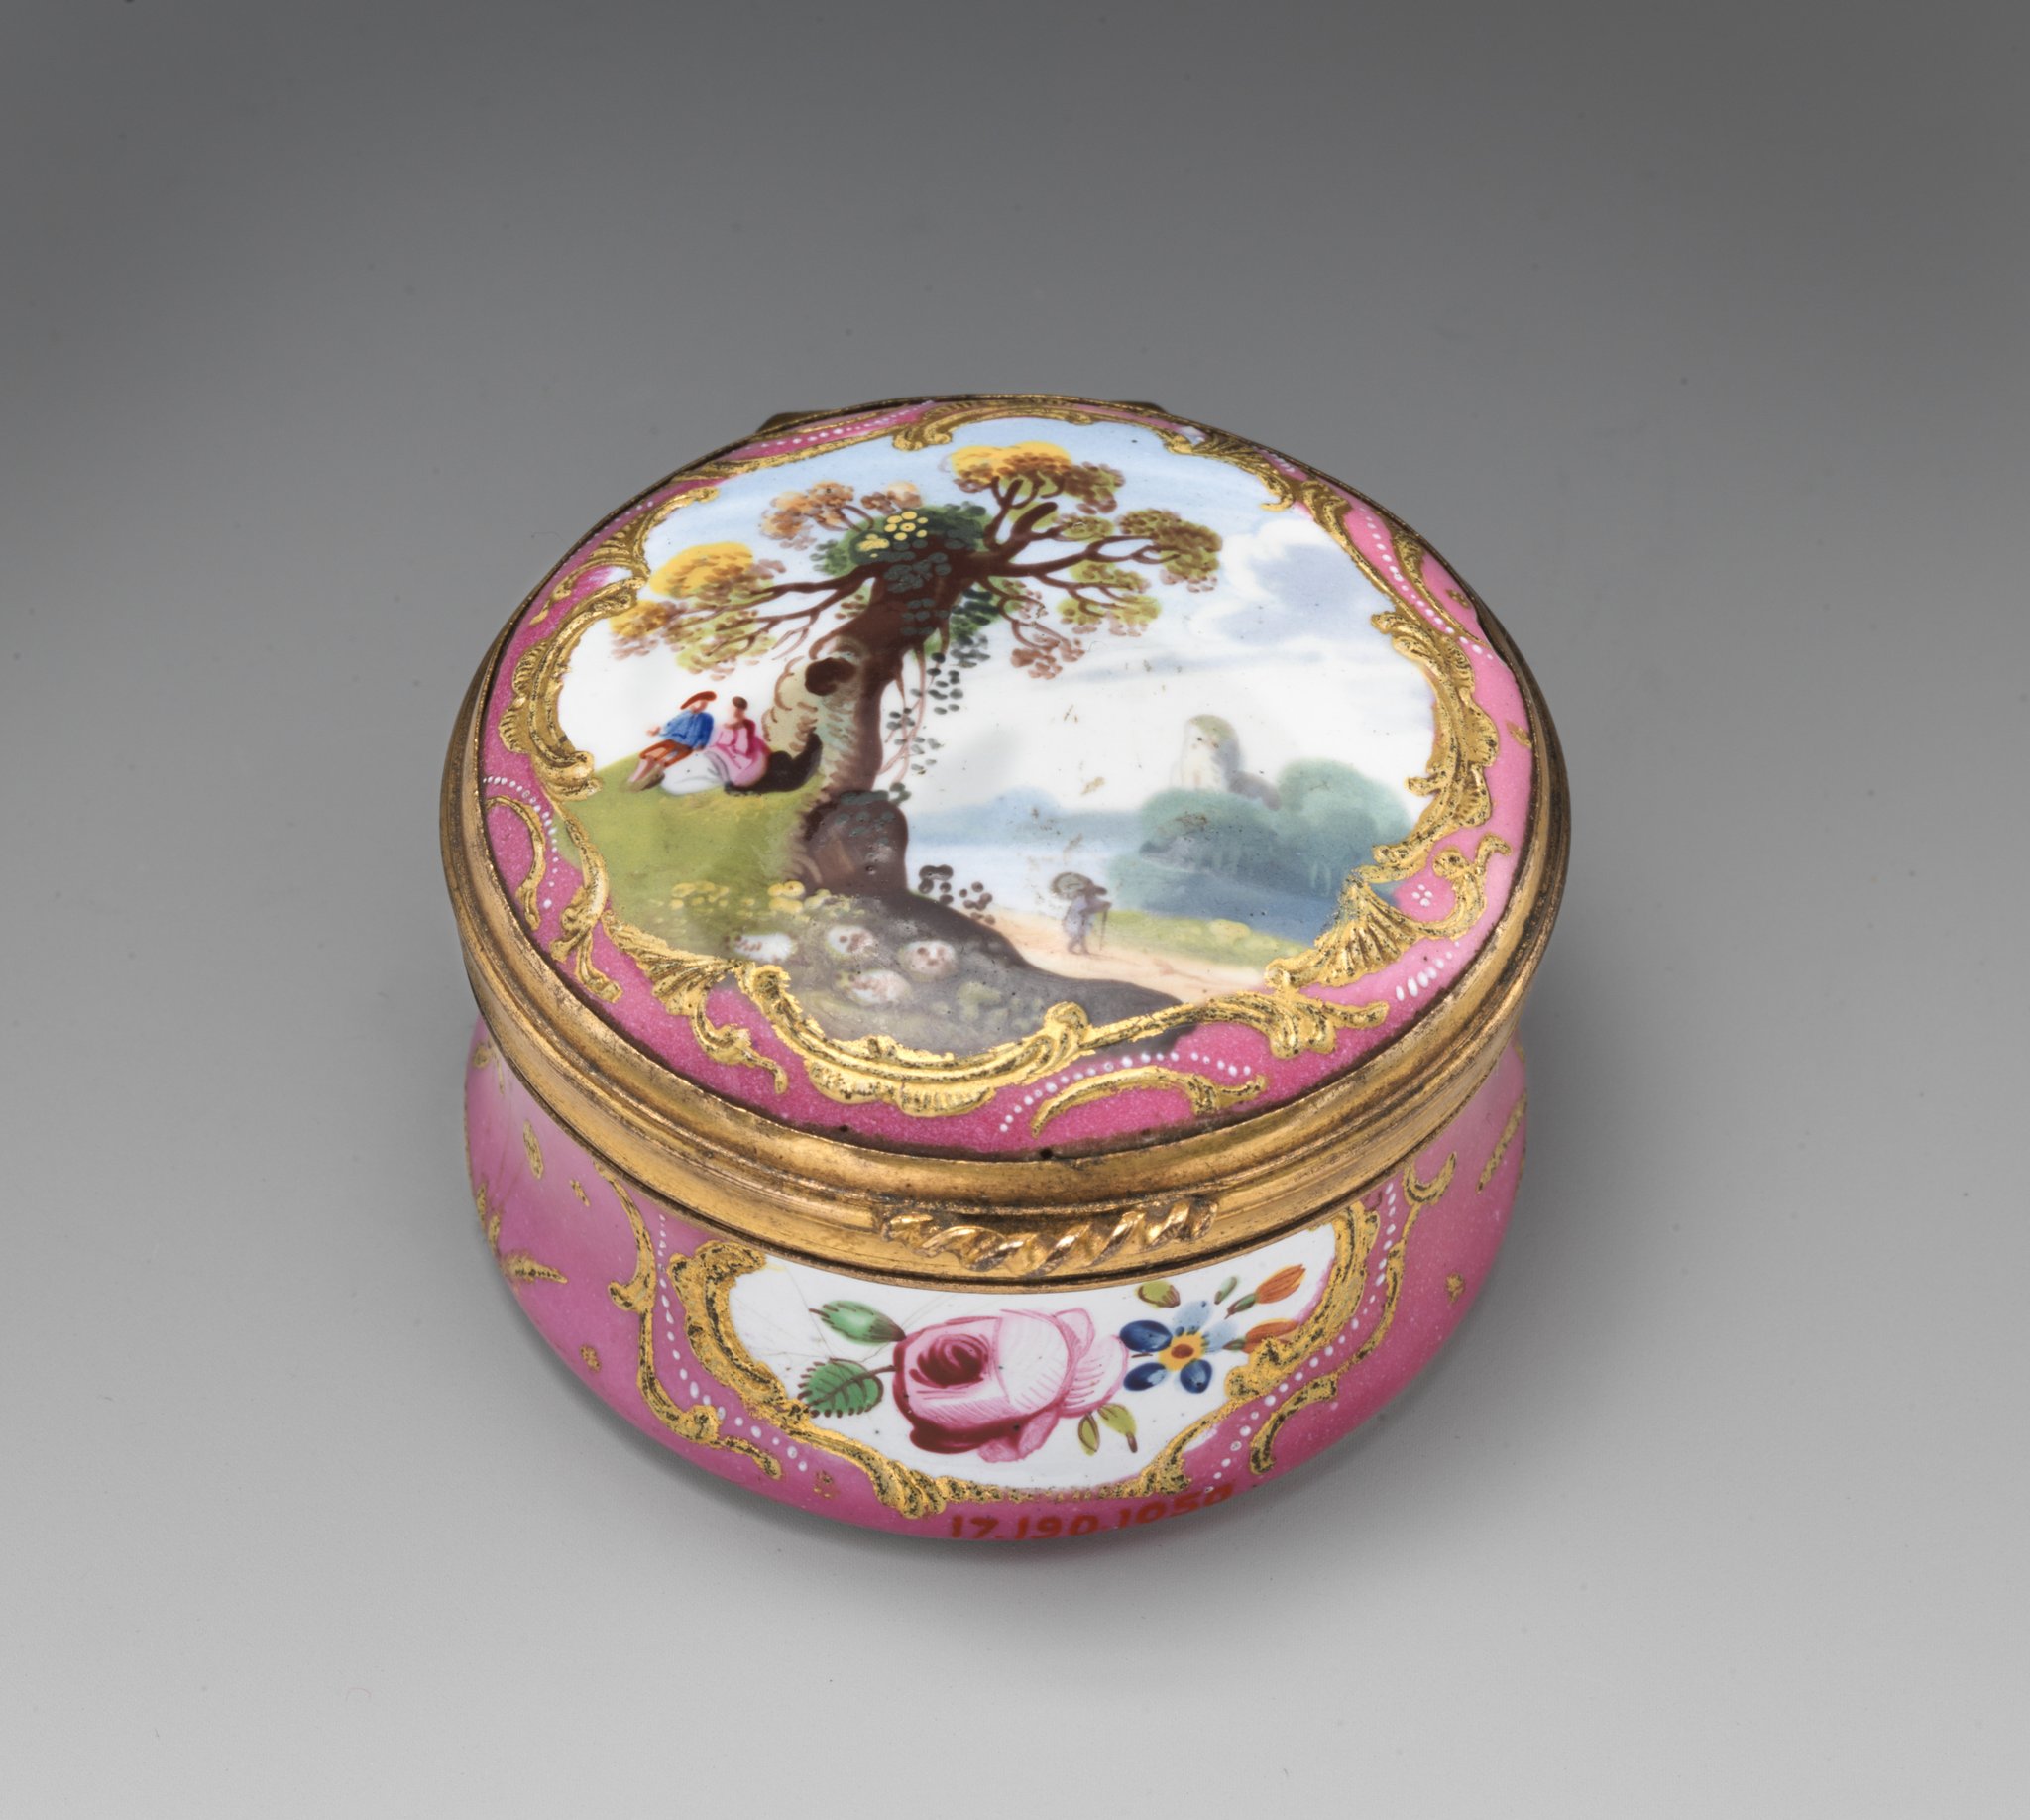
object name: snuffbox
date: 1765-1770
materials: copper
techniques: enamel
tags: flowers